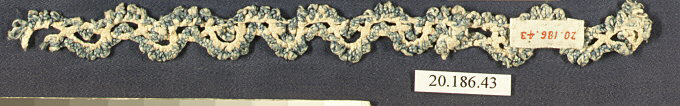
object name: edging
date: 1501-1600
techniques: lace